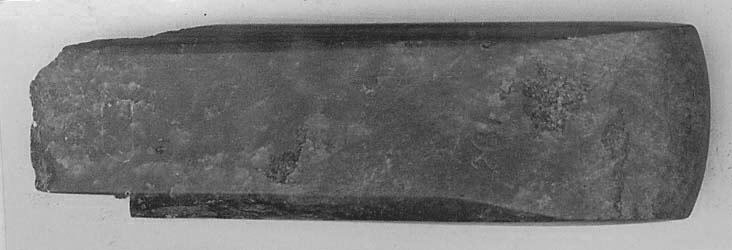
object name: hatchet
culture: asian or american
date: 1902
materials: jade